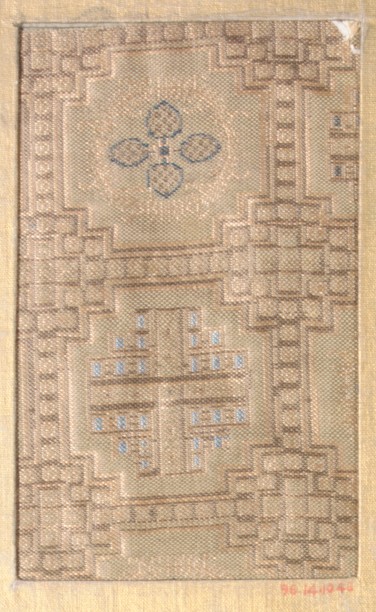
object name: piece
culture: japanese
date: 1701-1900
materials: silk